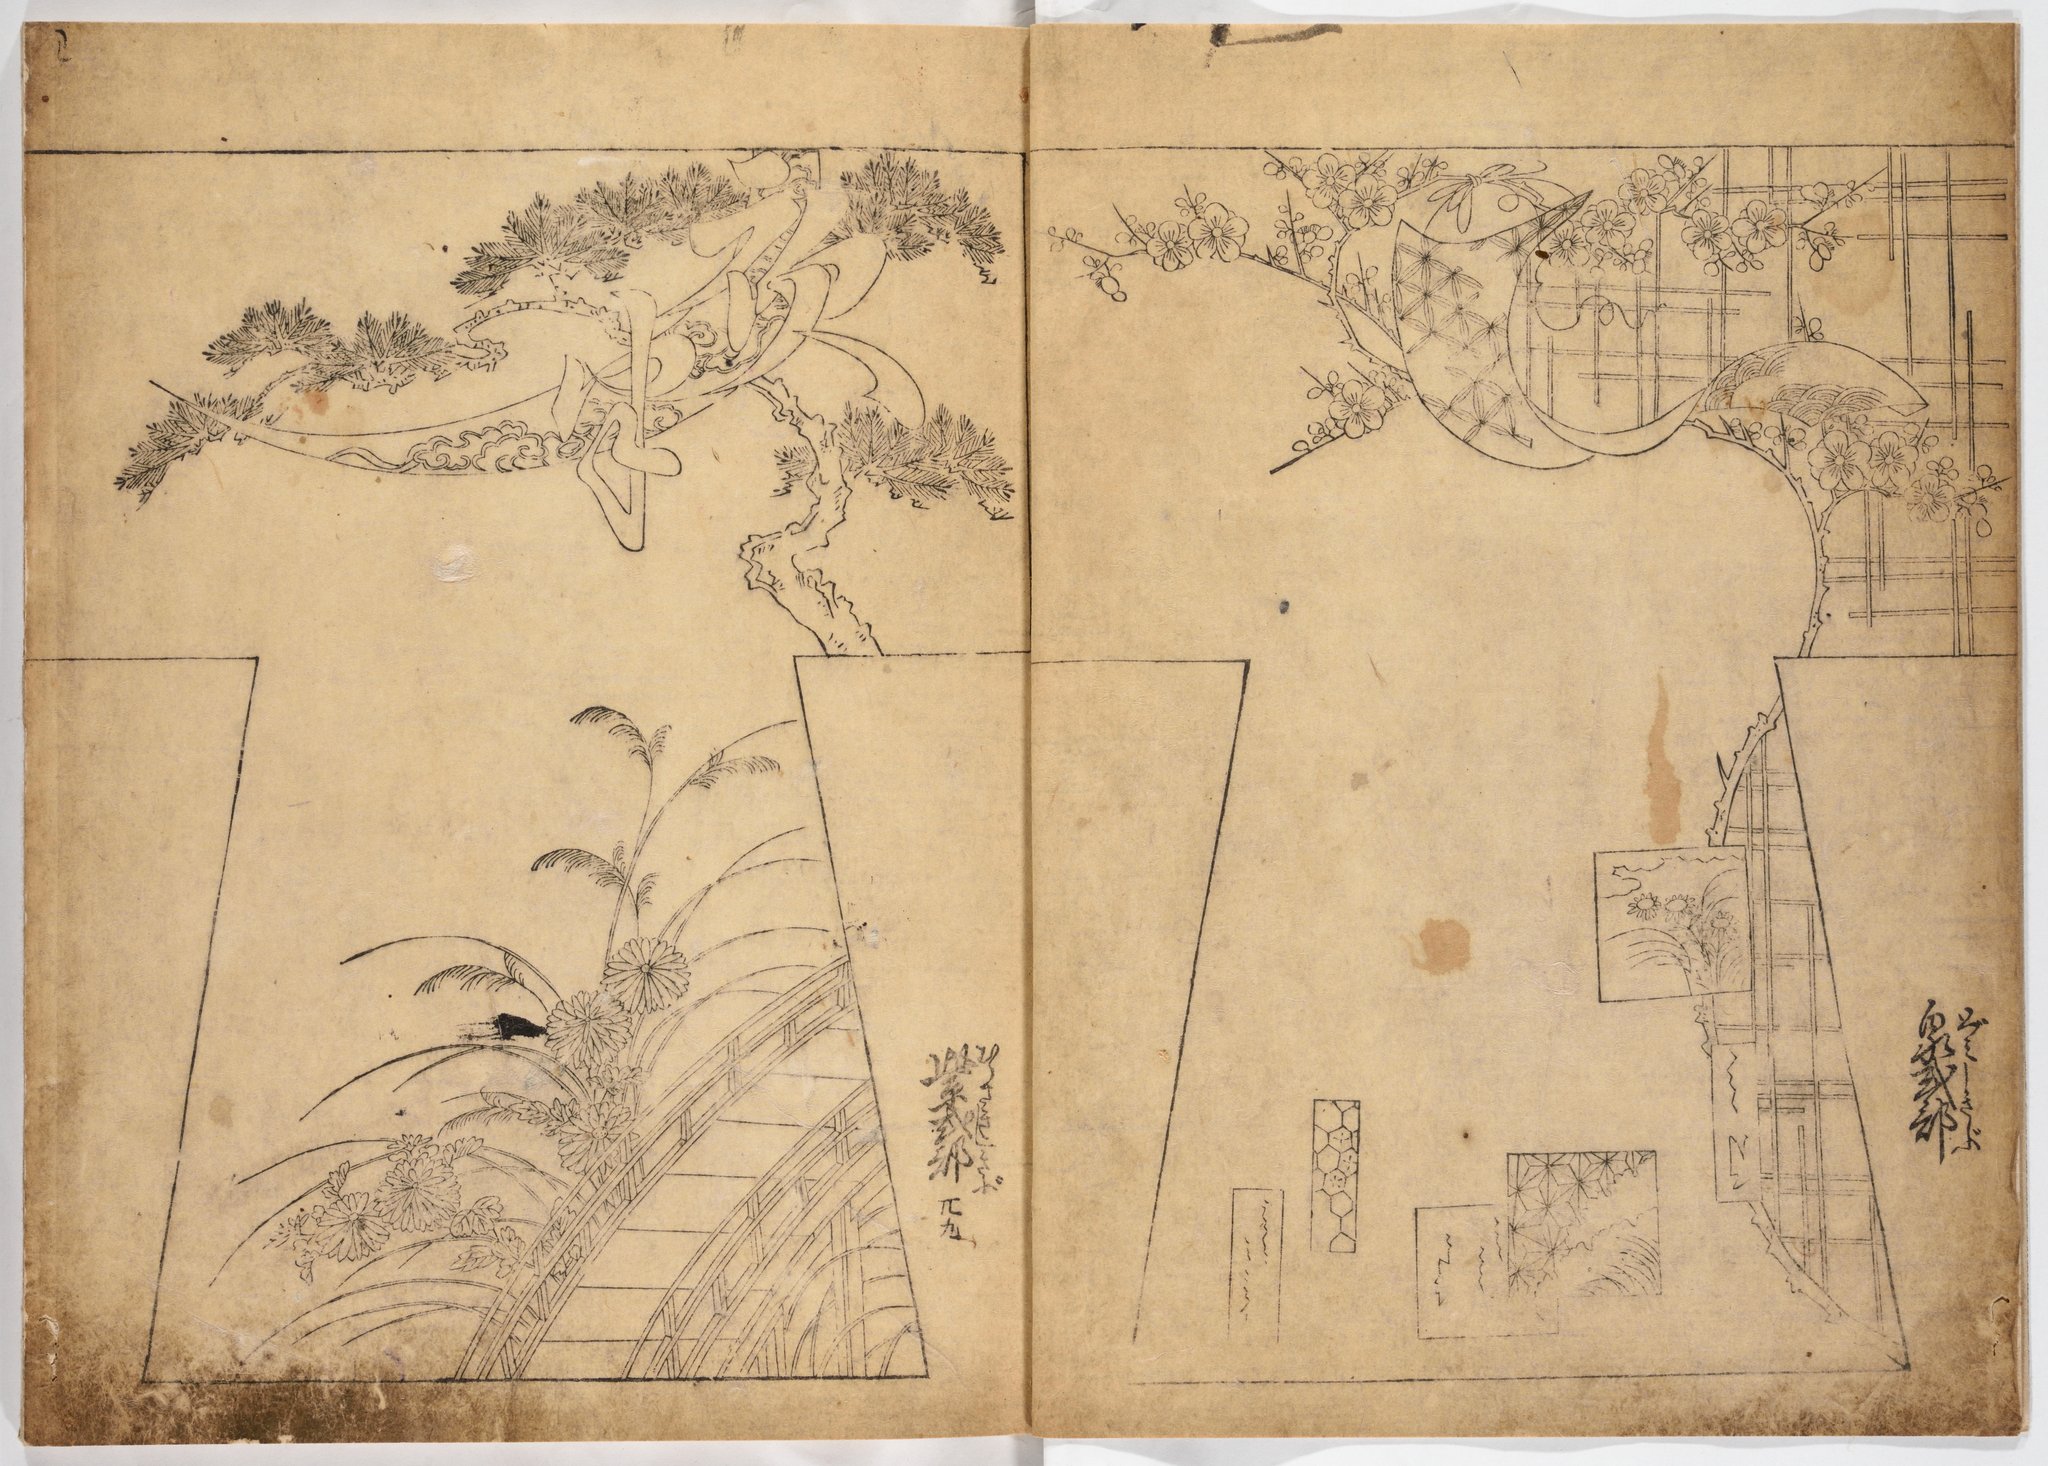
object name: illustrated book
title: Untitled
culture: japanese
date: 1701-1733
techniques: woodblock print